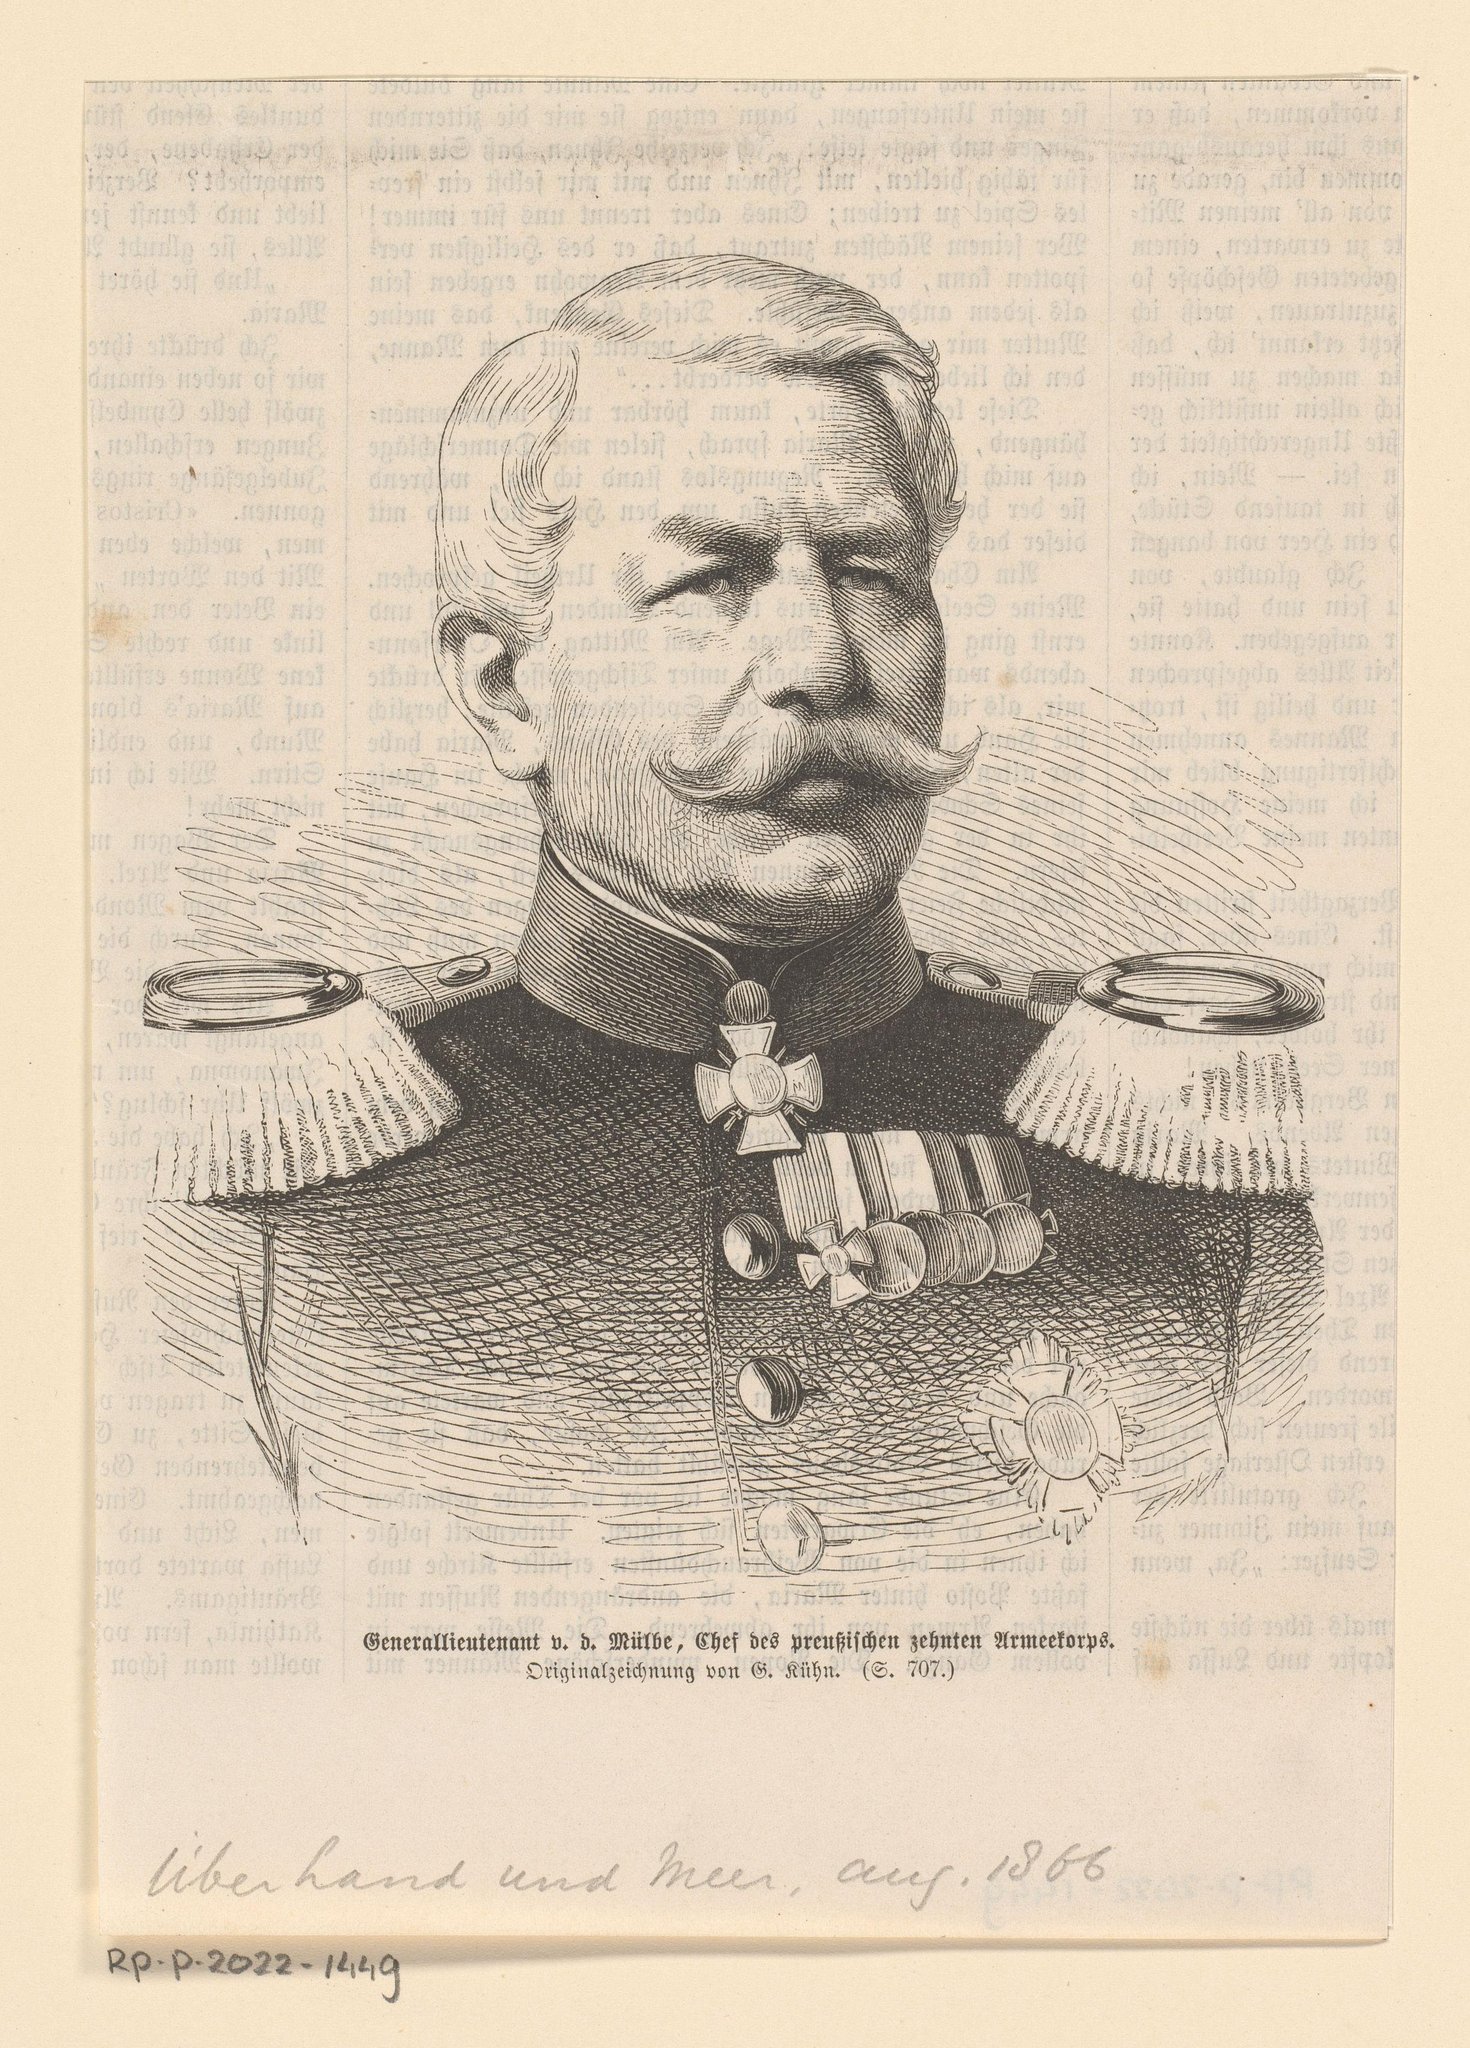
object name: print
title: Generallieutenant v. d. Mülbe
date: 1866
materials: paper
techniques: letterpress printing, engraving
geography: stuttgart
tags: commander-in-chief, general, marshal, historical persons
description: Prent uit: Über Land und Meer 16 (1866), p. 705.